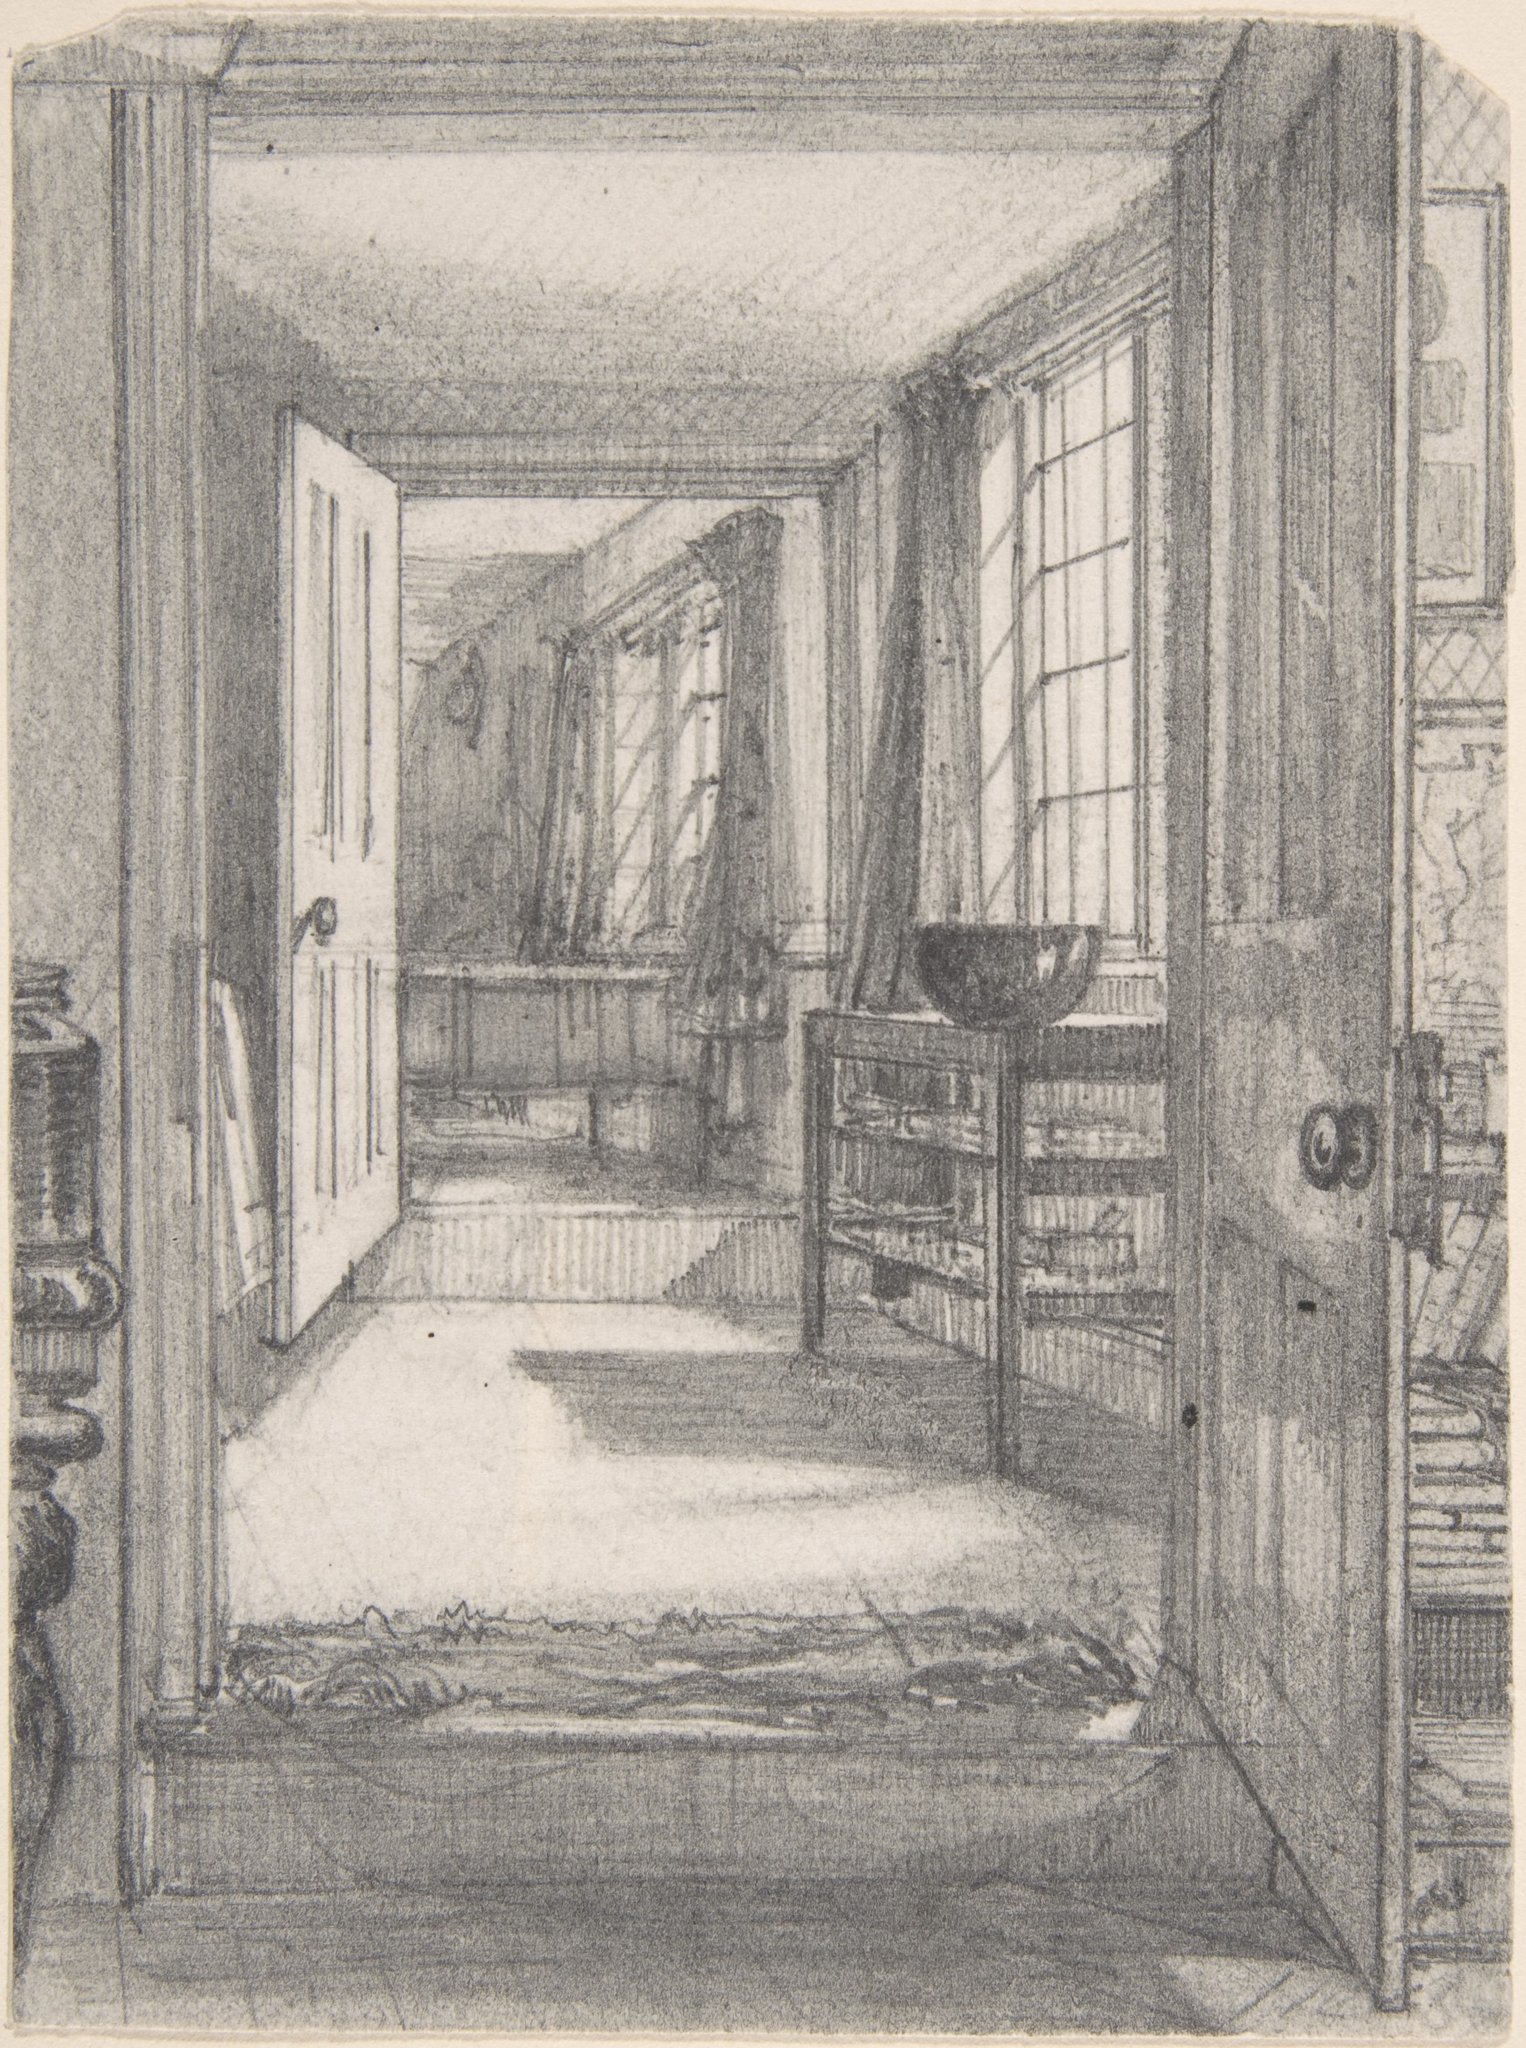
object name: drawing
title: A Cottage Parlour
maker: francis seymour haden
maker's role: artist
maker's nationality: british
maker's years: 1818-1910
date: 1838-1910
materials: graphite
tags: doorways,windows,interiors,tables